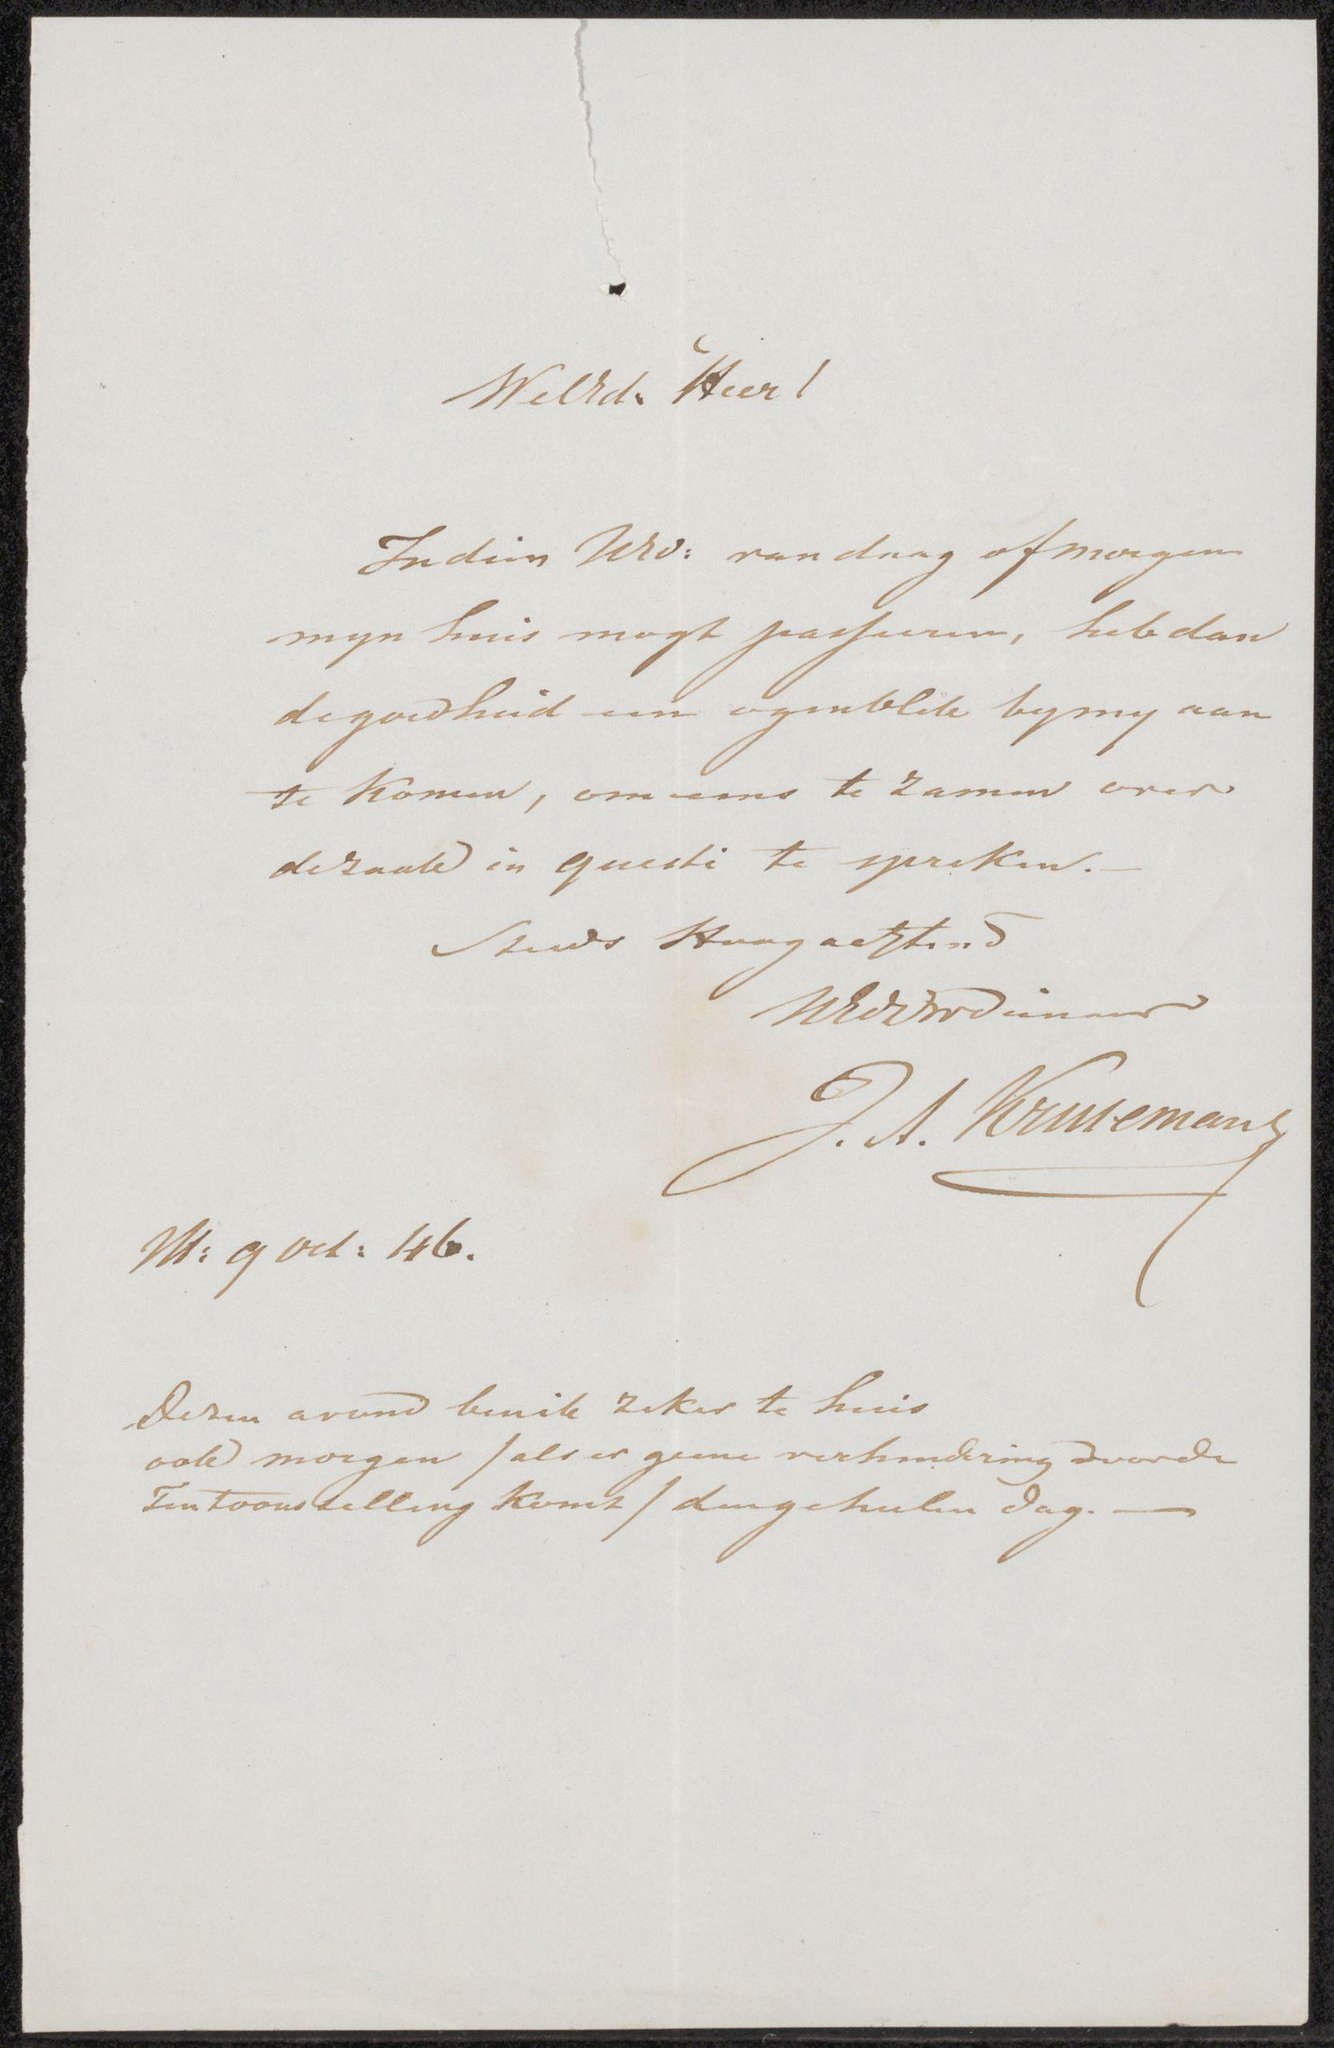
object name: letter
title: Brief aan anoniem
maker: jan adam kruseman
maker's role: draughtsman, painter, print maker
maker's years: 1804-1862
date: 1846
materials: ink, paper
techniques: pen, writing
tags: exhibition ~ art